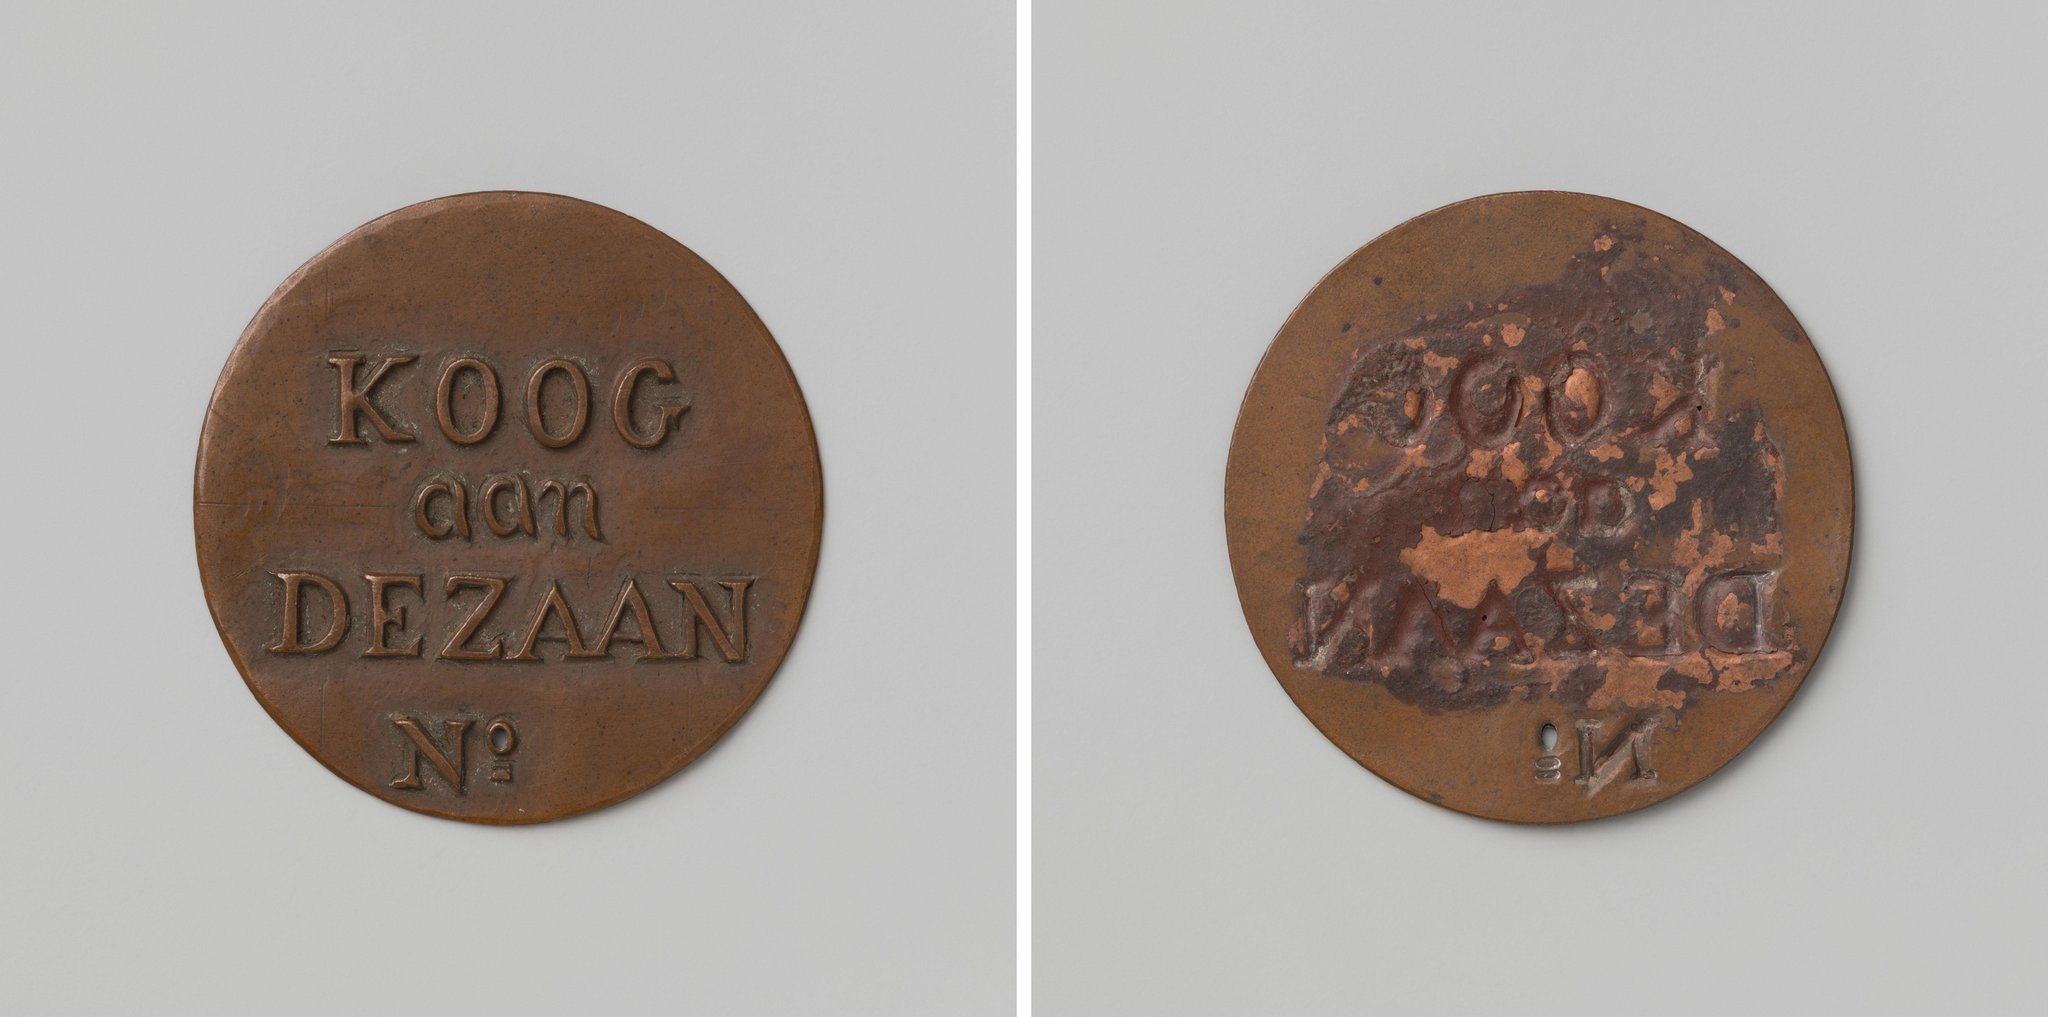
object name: fire engine medal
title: Brandspuitpenning van Koog aan de Zaan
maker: Anonymous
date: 1700-1880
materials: copper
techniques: casting, galvanization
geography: koog aan de zaan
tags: koog aan de zaan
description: Eenzijdige koperen penning. Voorzijde: opschrift. Keerzijde: blanco